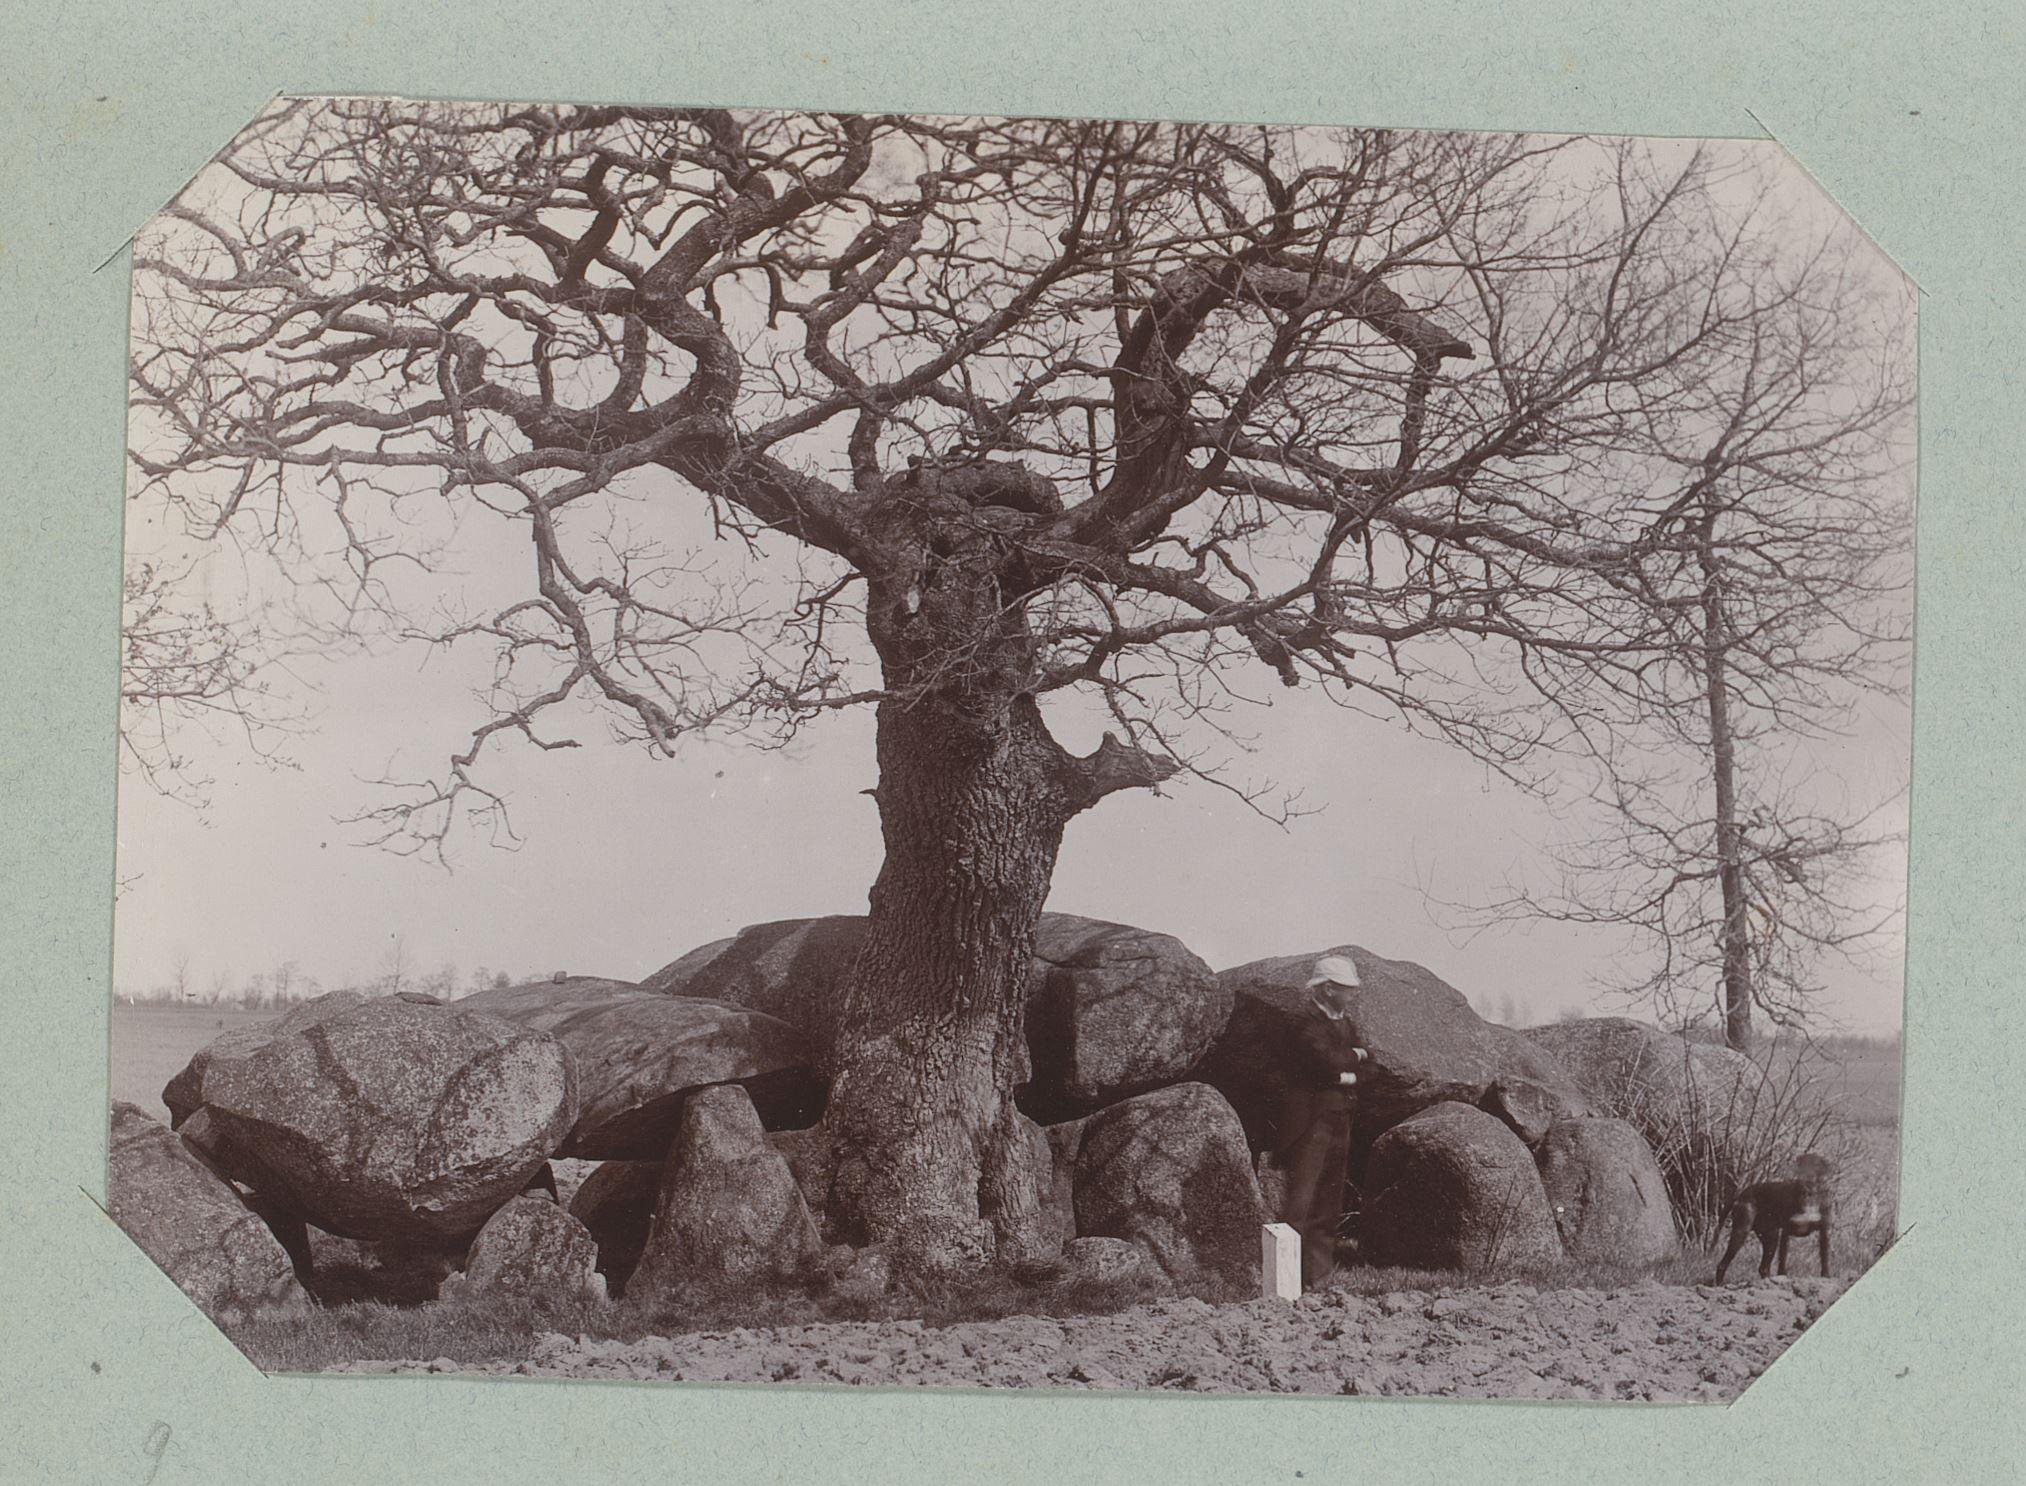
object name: photograph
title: Man en hond bij het hunebed van Rolde, bij Assen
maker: johannes gerardus kramer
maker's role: fotograaf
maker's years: 1845-1903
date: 1885-1895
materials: paper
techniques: collodion silver print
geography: rolde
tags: trees, megalithic chambered tomb, dolmen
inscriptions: inscription: ‘De Hunnebedden te Rolde 5 kwartier/ loopens van Assen (heen en terug) -/ Sept-Oct: 1900’